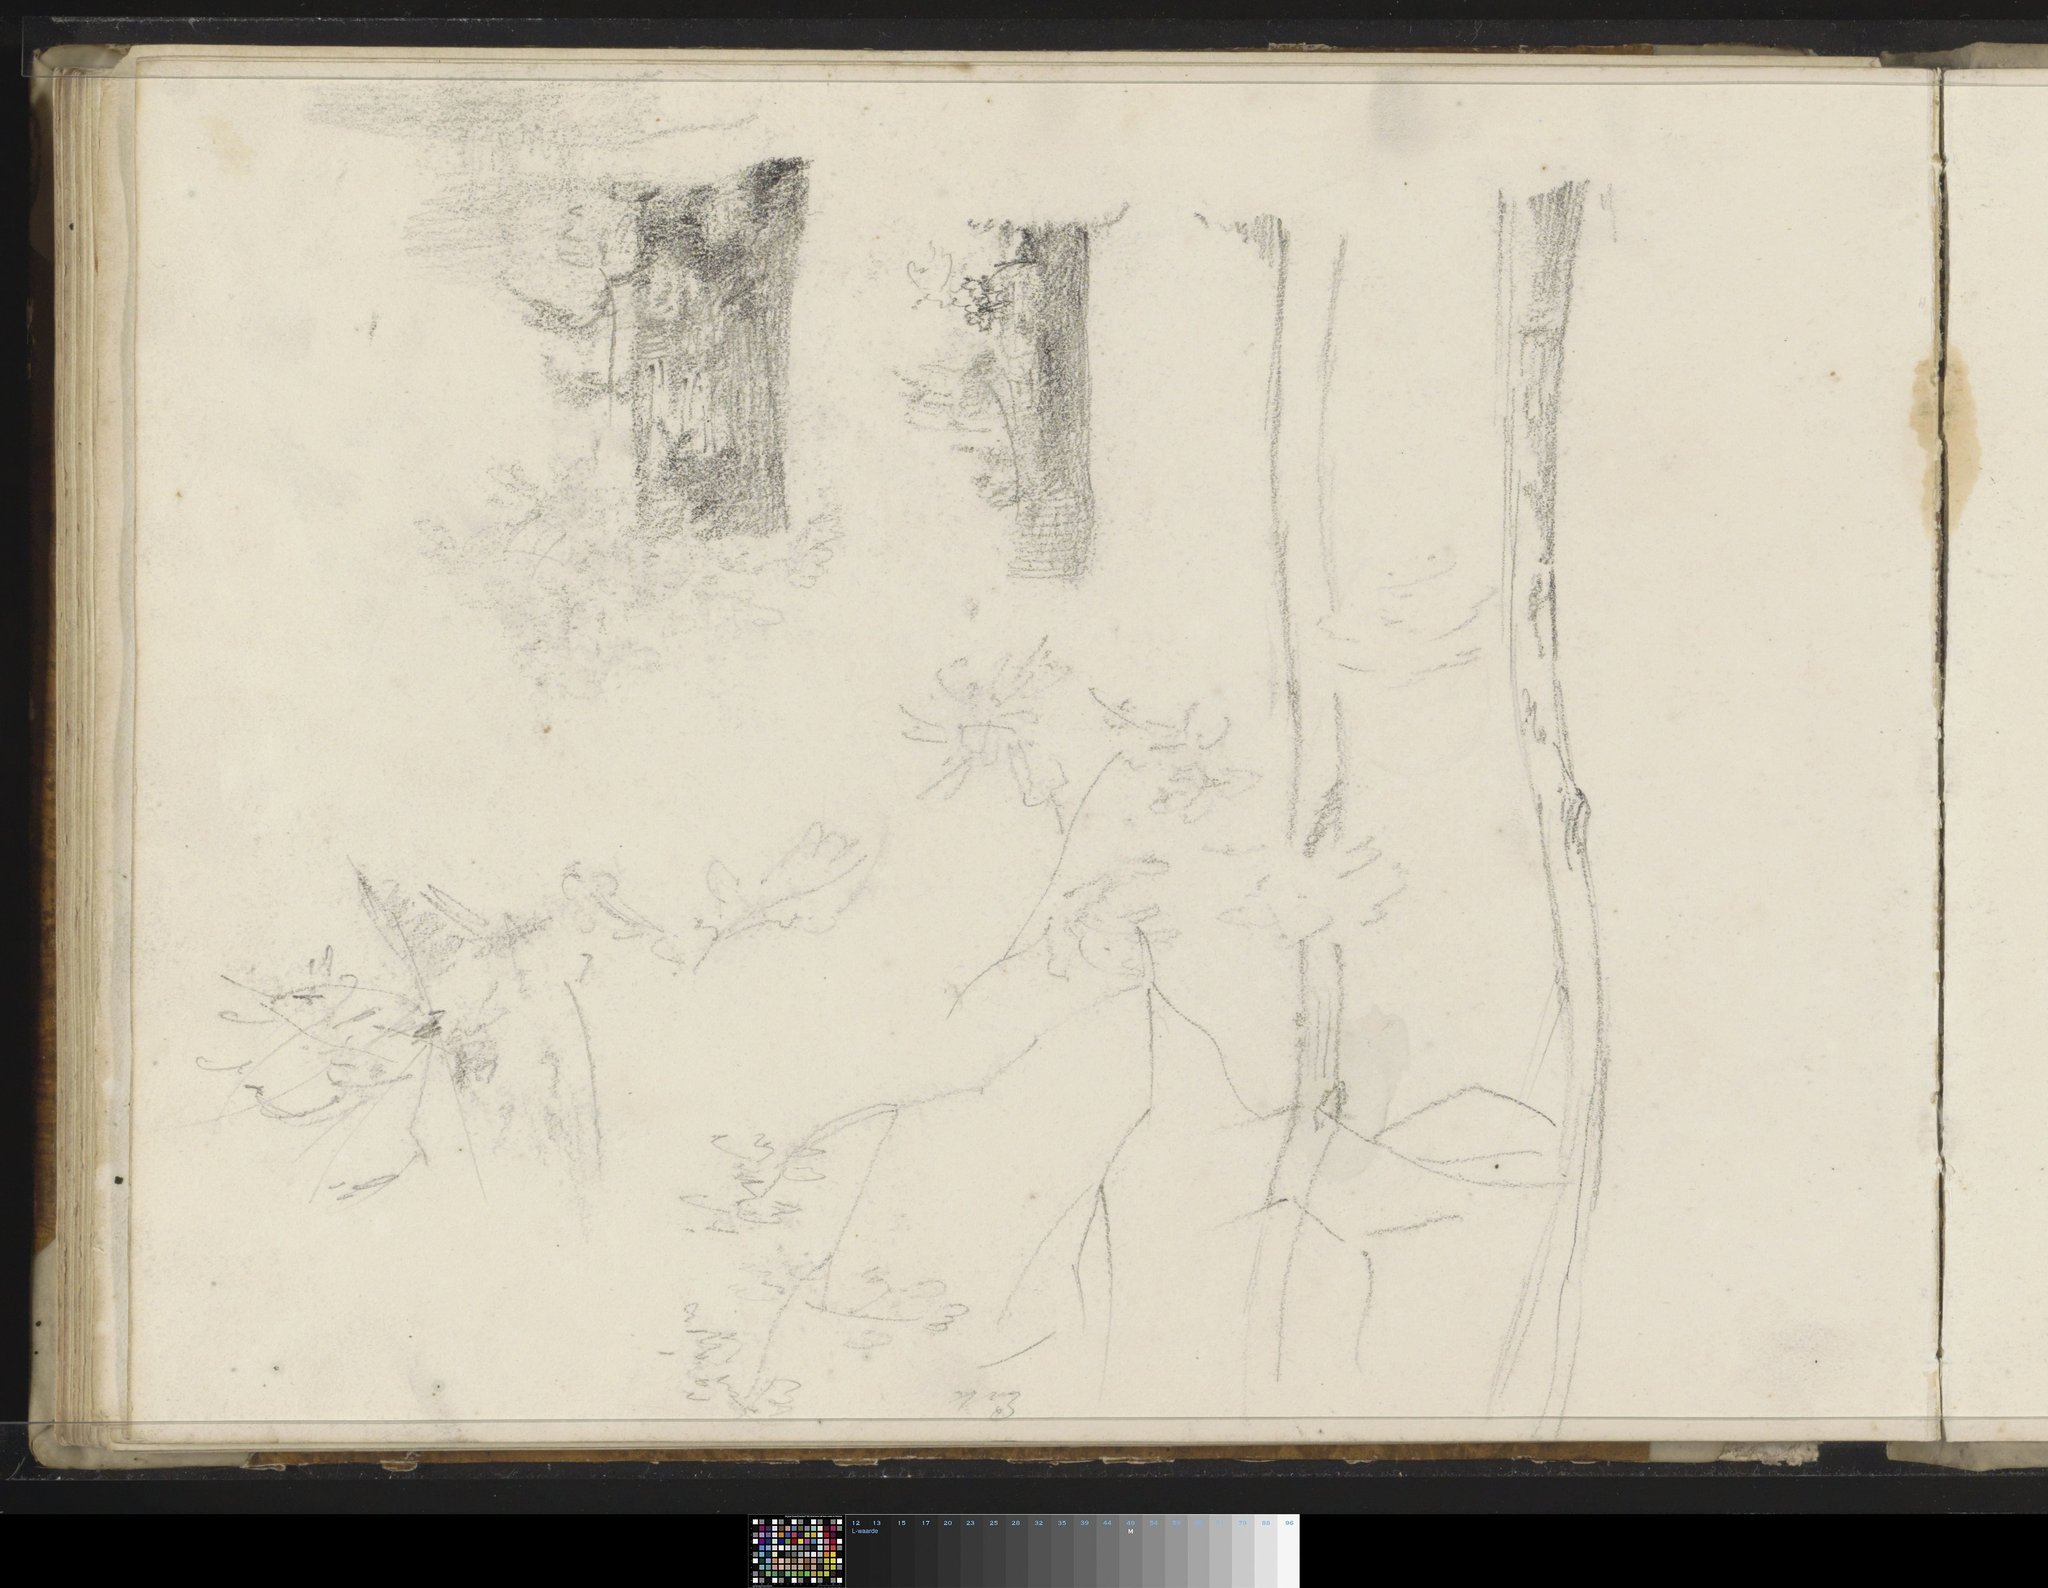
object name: sketchbook leaf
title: Boomstammen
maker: maria vos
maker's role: draughtsman, painter, print maker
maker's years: 1824-1906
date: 1834-1906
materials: paper, pencil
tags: trees (+ stem, trunk)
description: Blad 38 verso uit een schetsboek met 39 bladen.